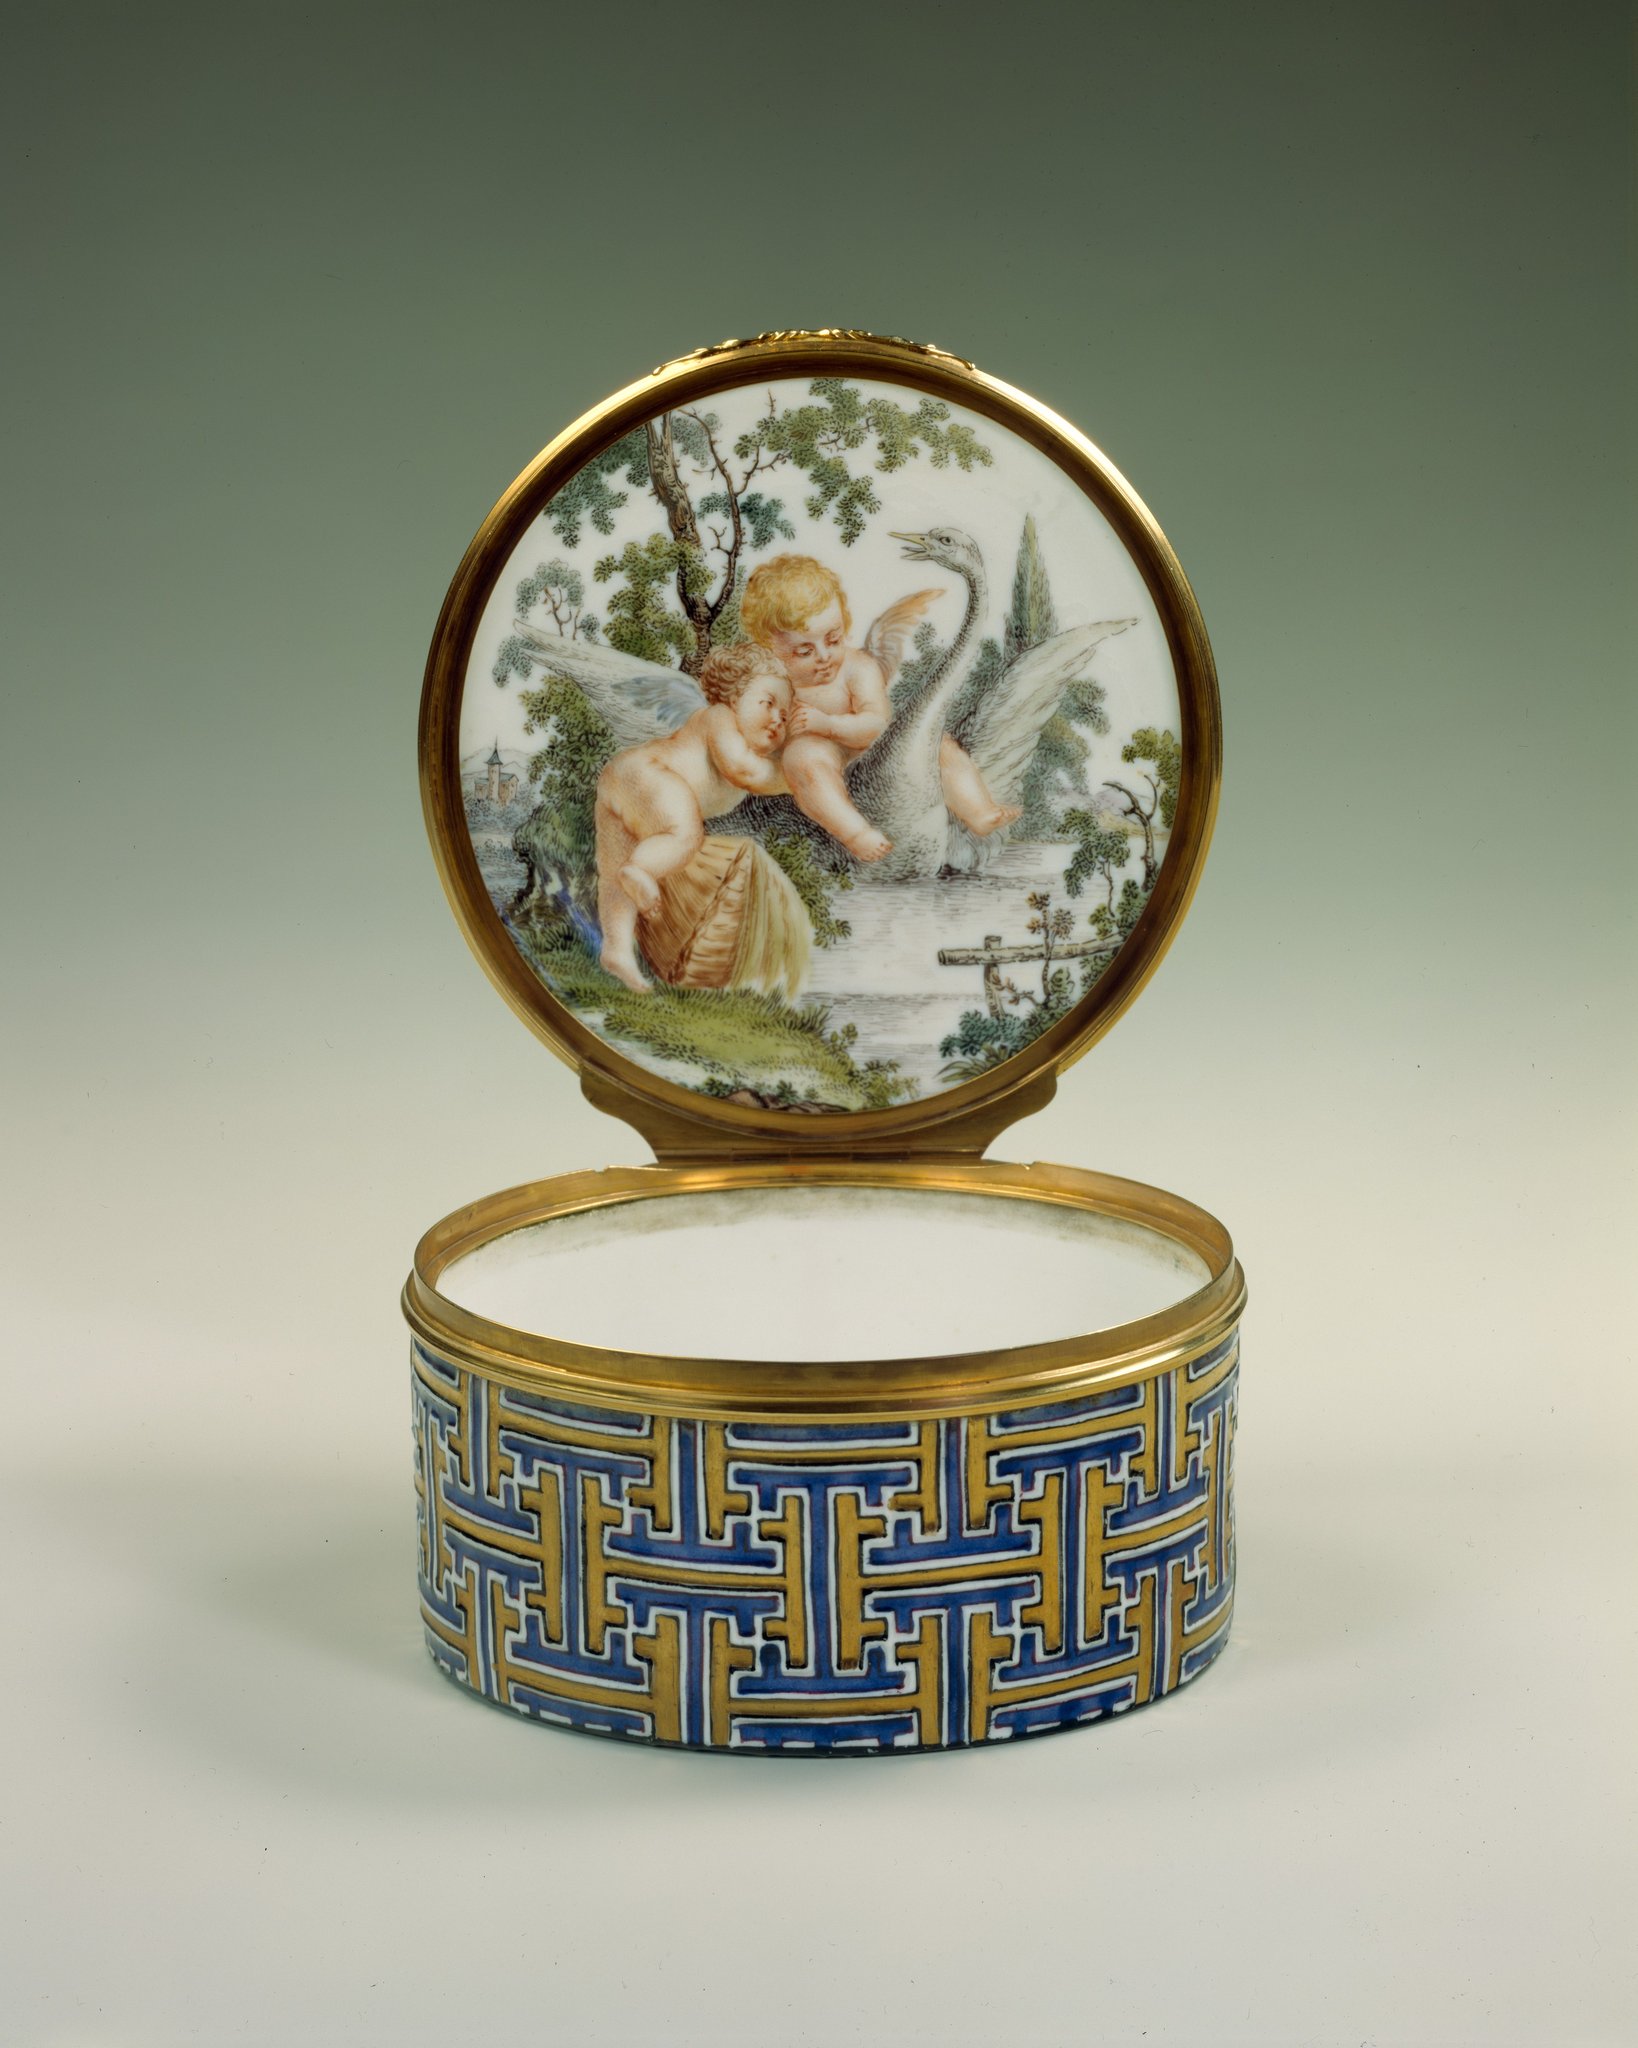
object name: snuffbox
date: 1770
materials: gold, hard paste porcelain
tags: putti,swans